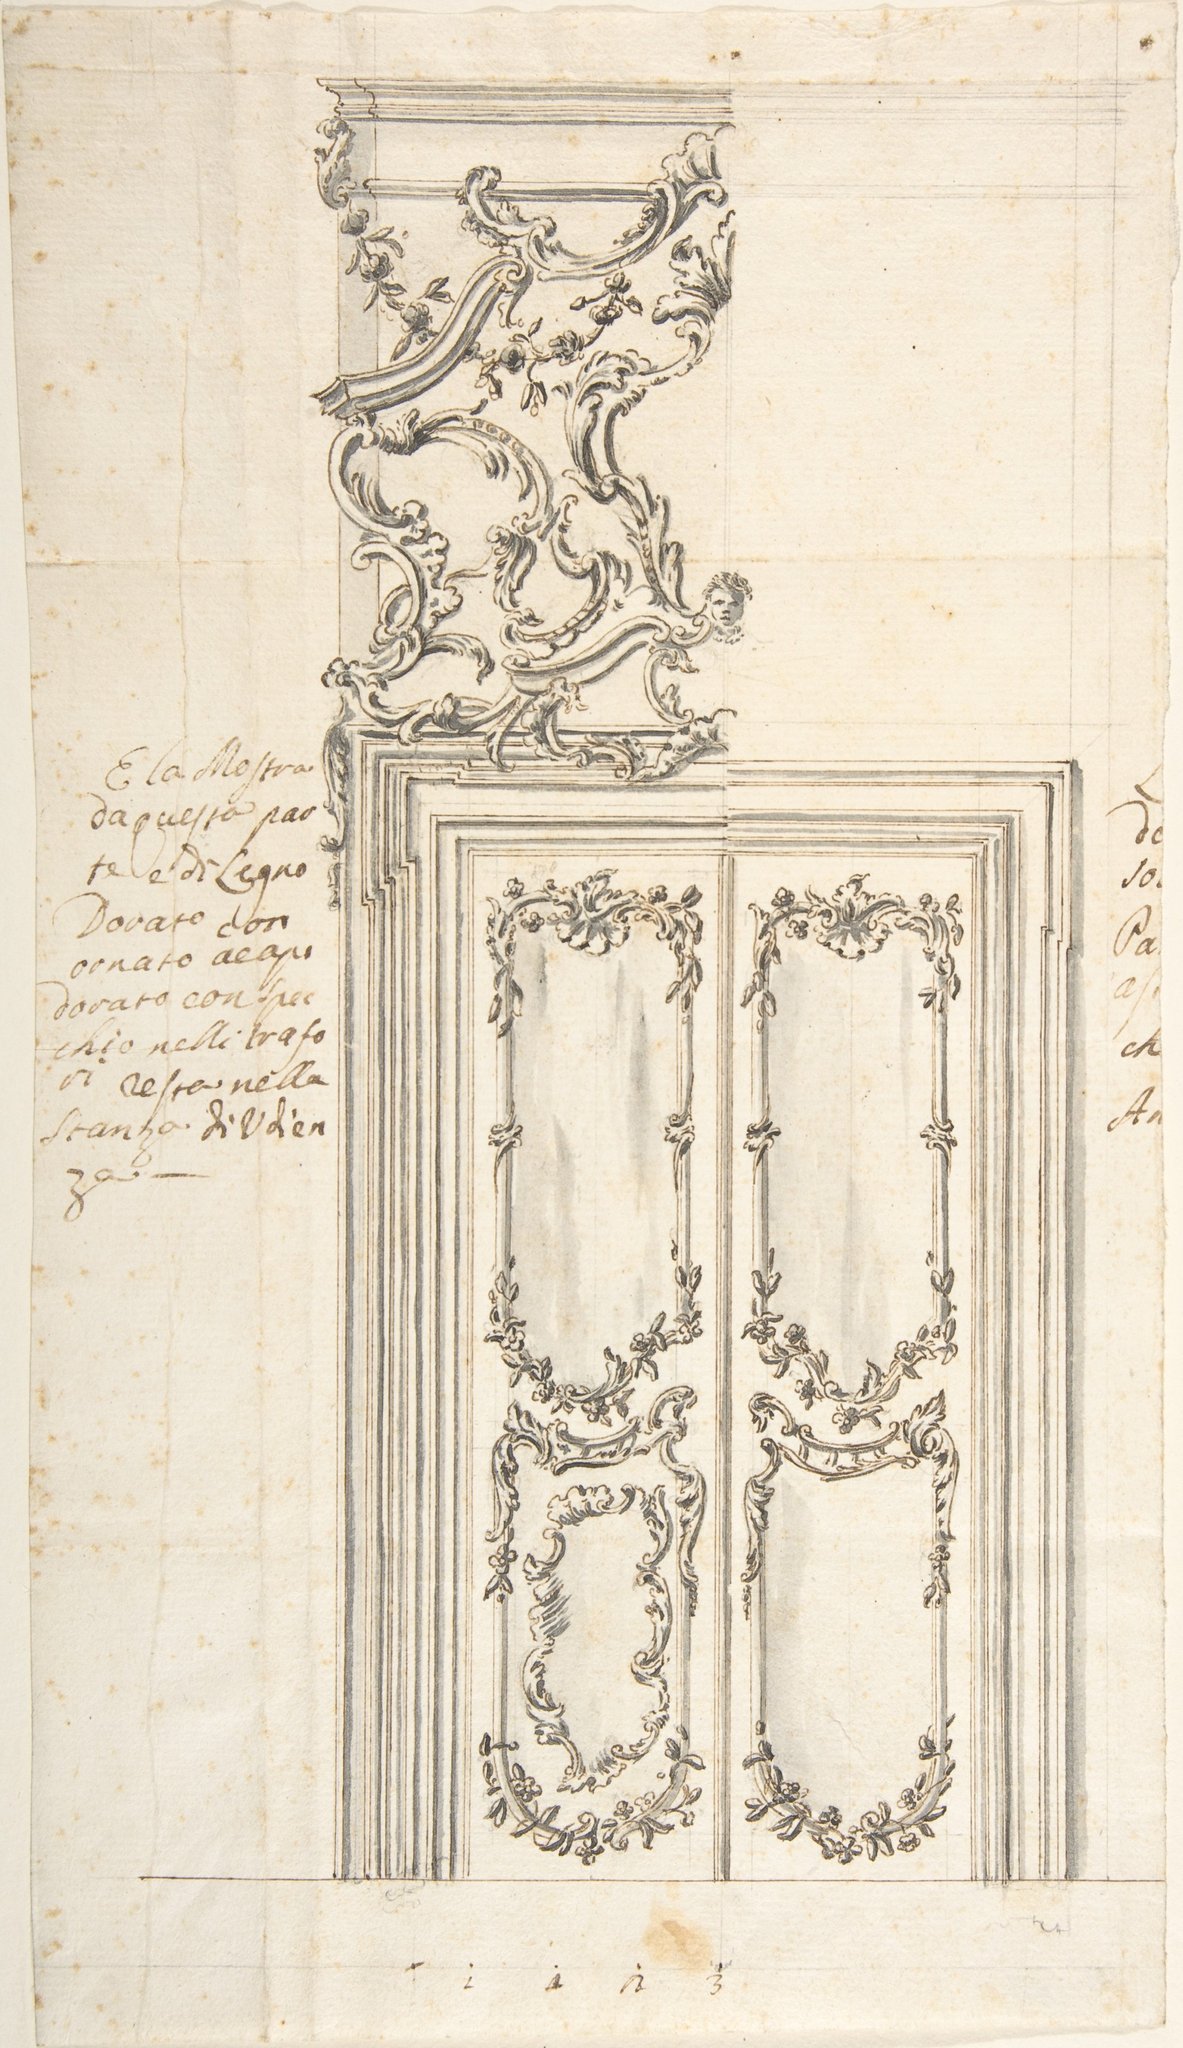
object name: drawing ornament architecture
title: Design for a Door and Stucco Overdoor Decorations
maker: anonymous, italian, 18th century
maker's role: artist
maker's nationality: italian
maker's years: 1700-1800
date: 1740-1760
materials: graphite, ink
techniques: pen, wash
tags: doors,ornament